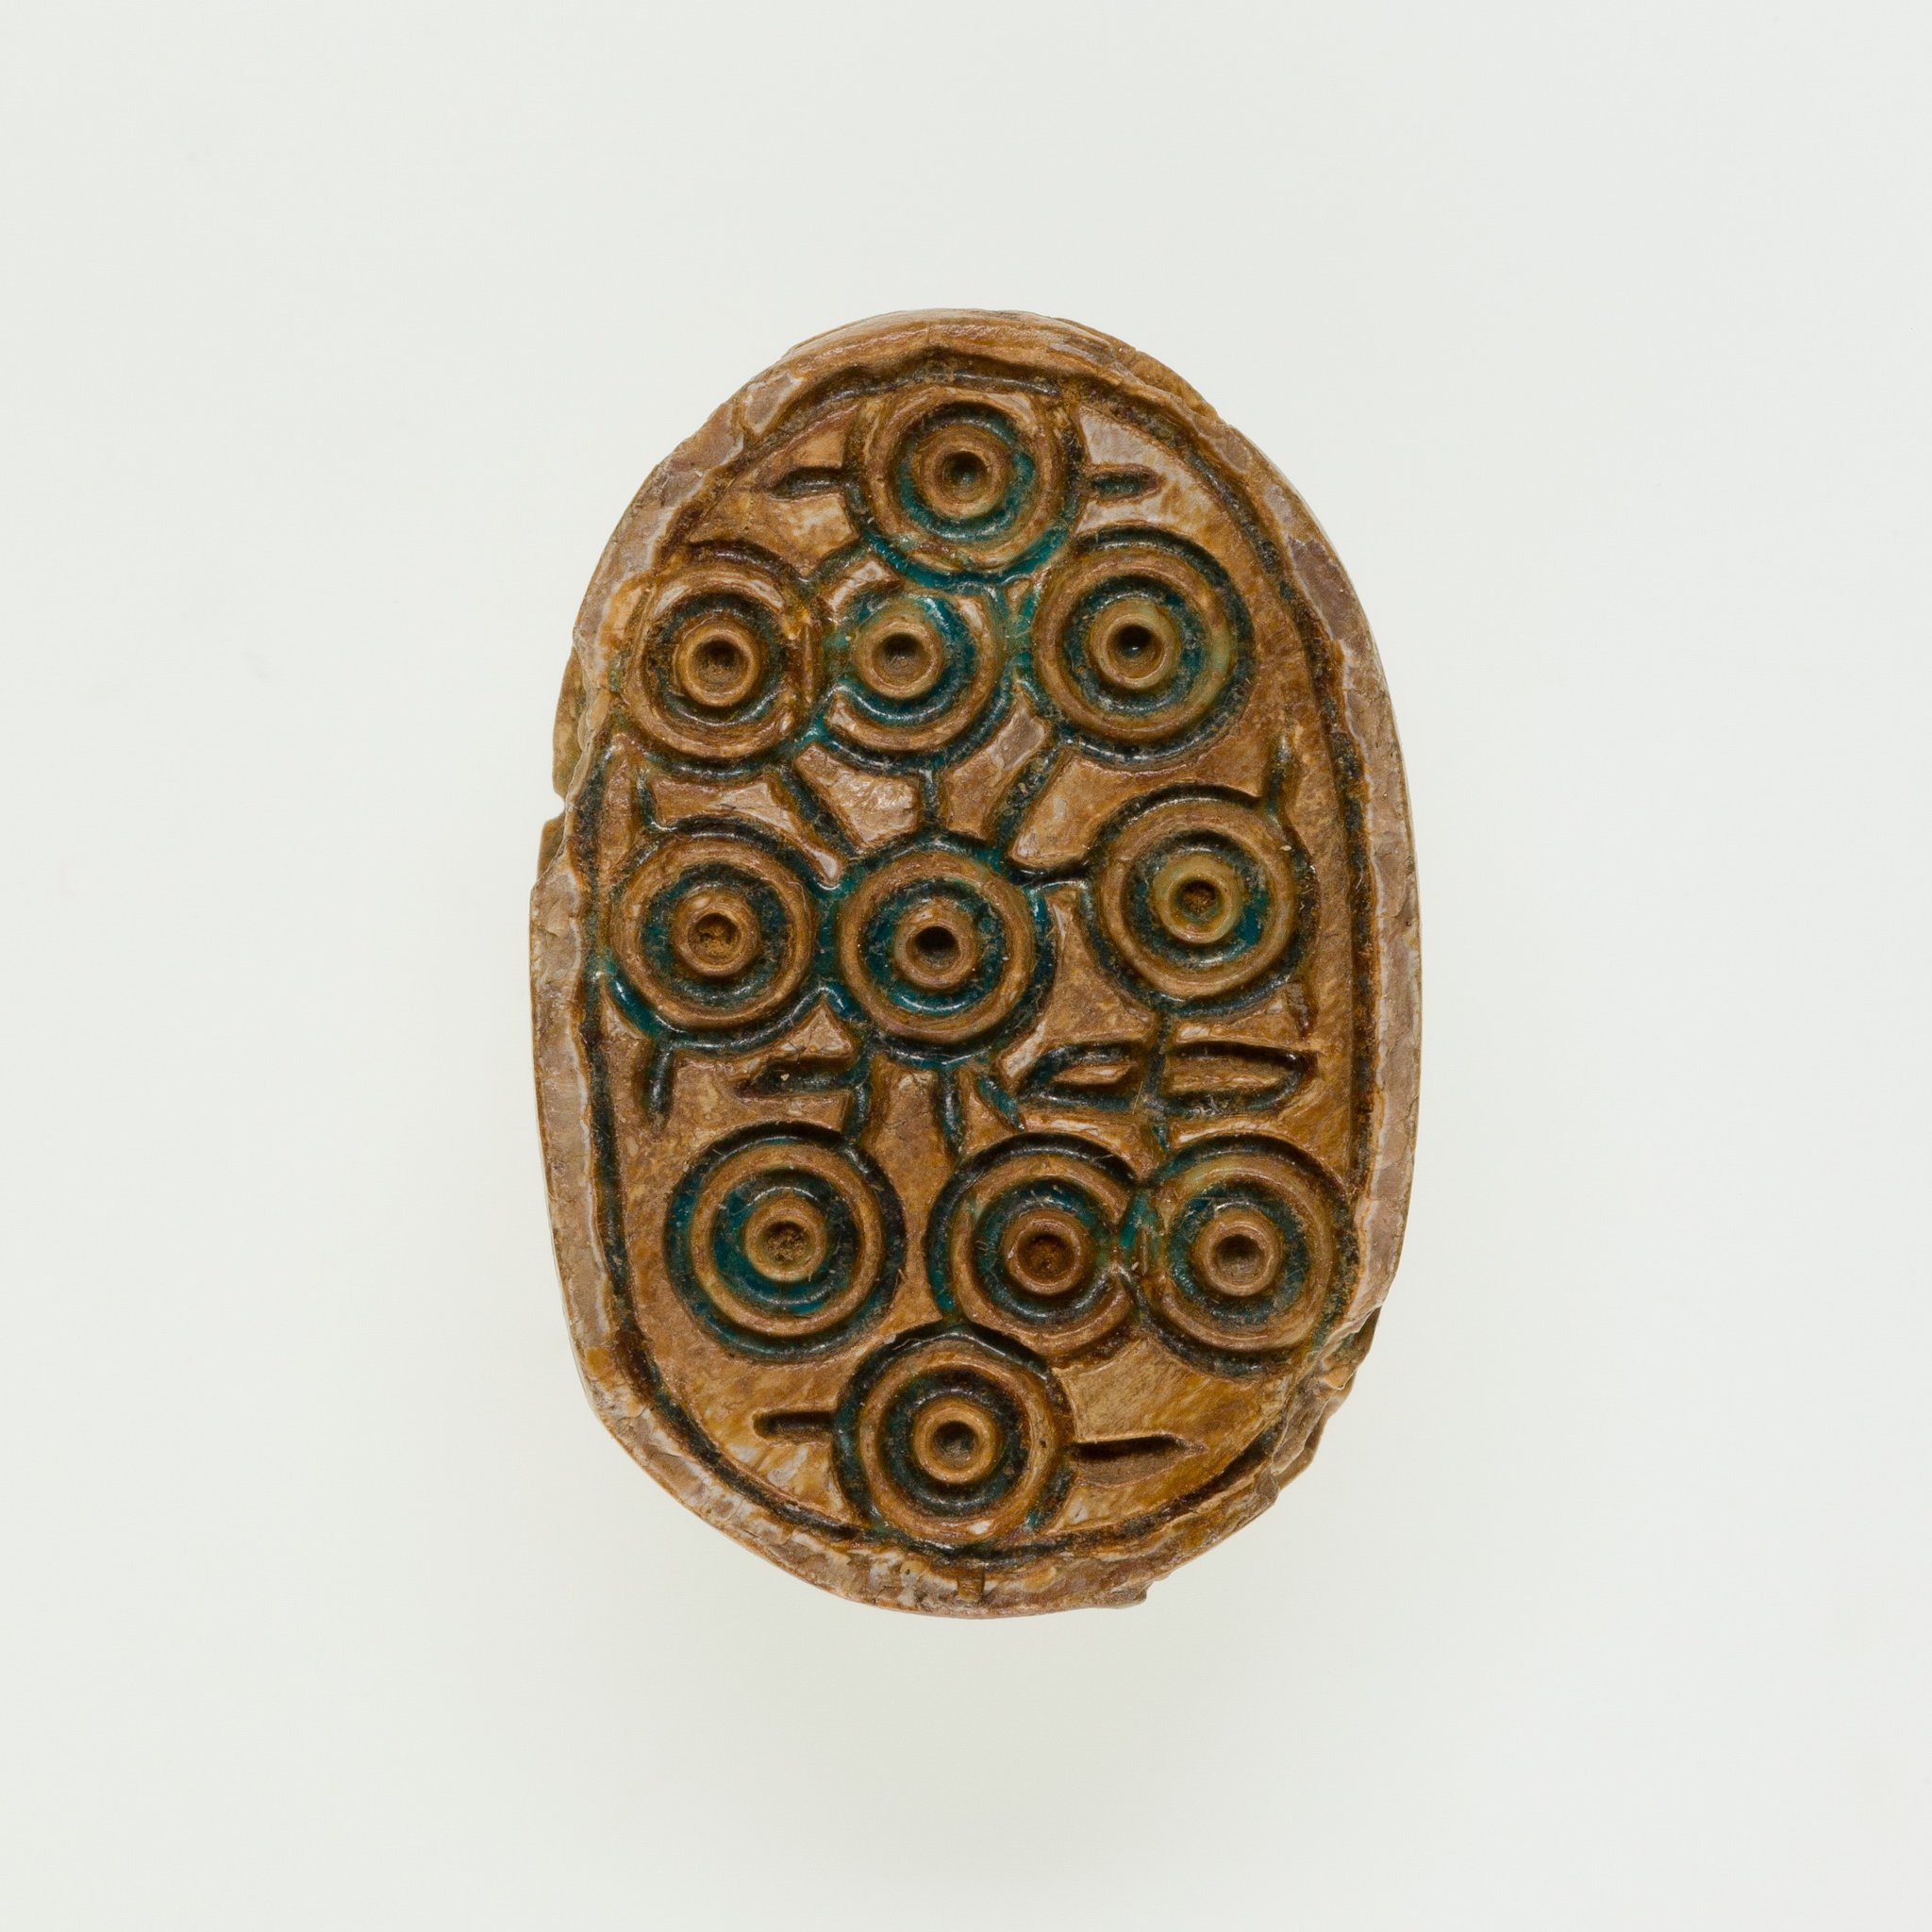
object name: scarab, linked circle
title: Scarab Decorated with Circles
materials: glaze, stone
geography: egypt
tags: scarabs